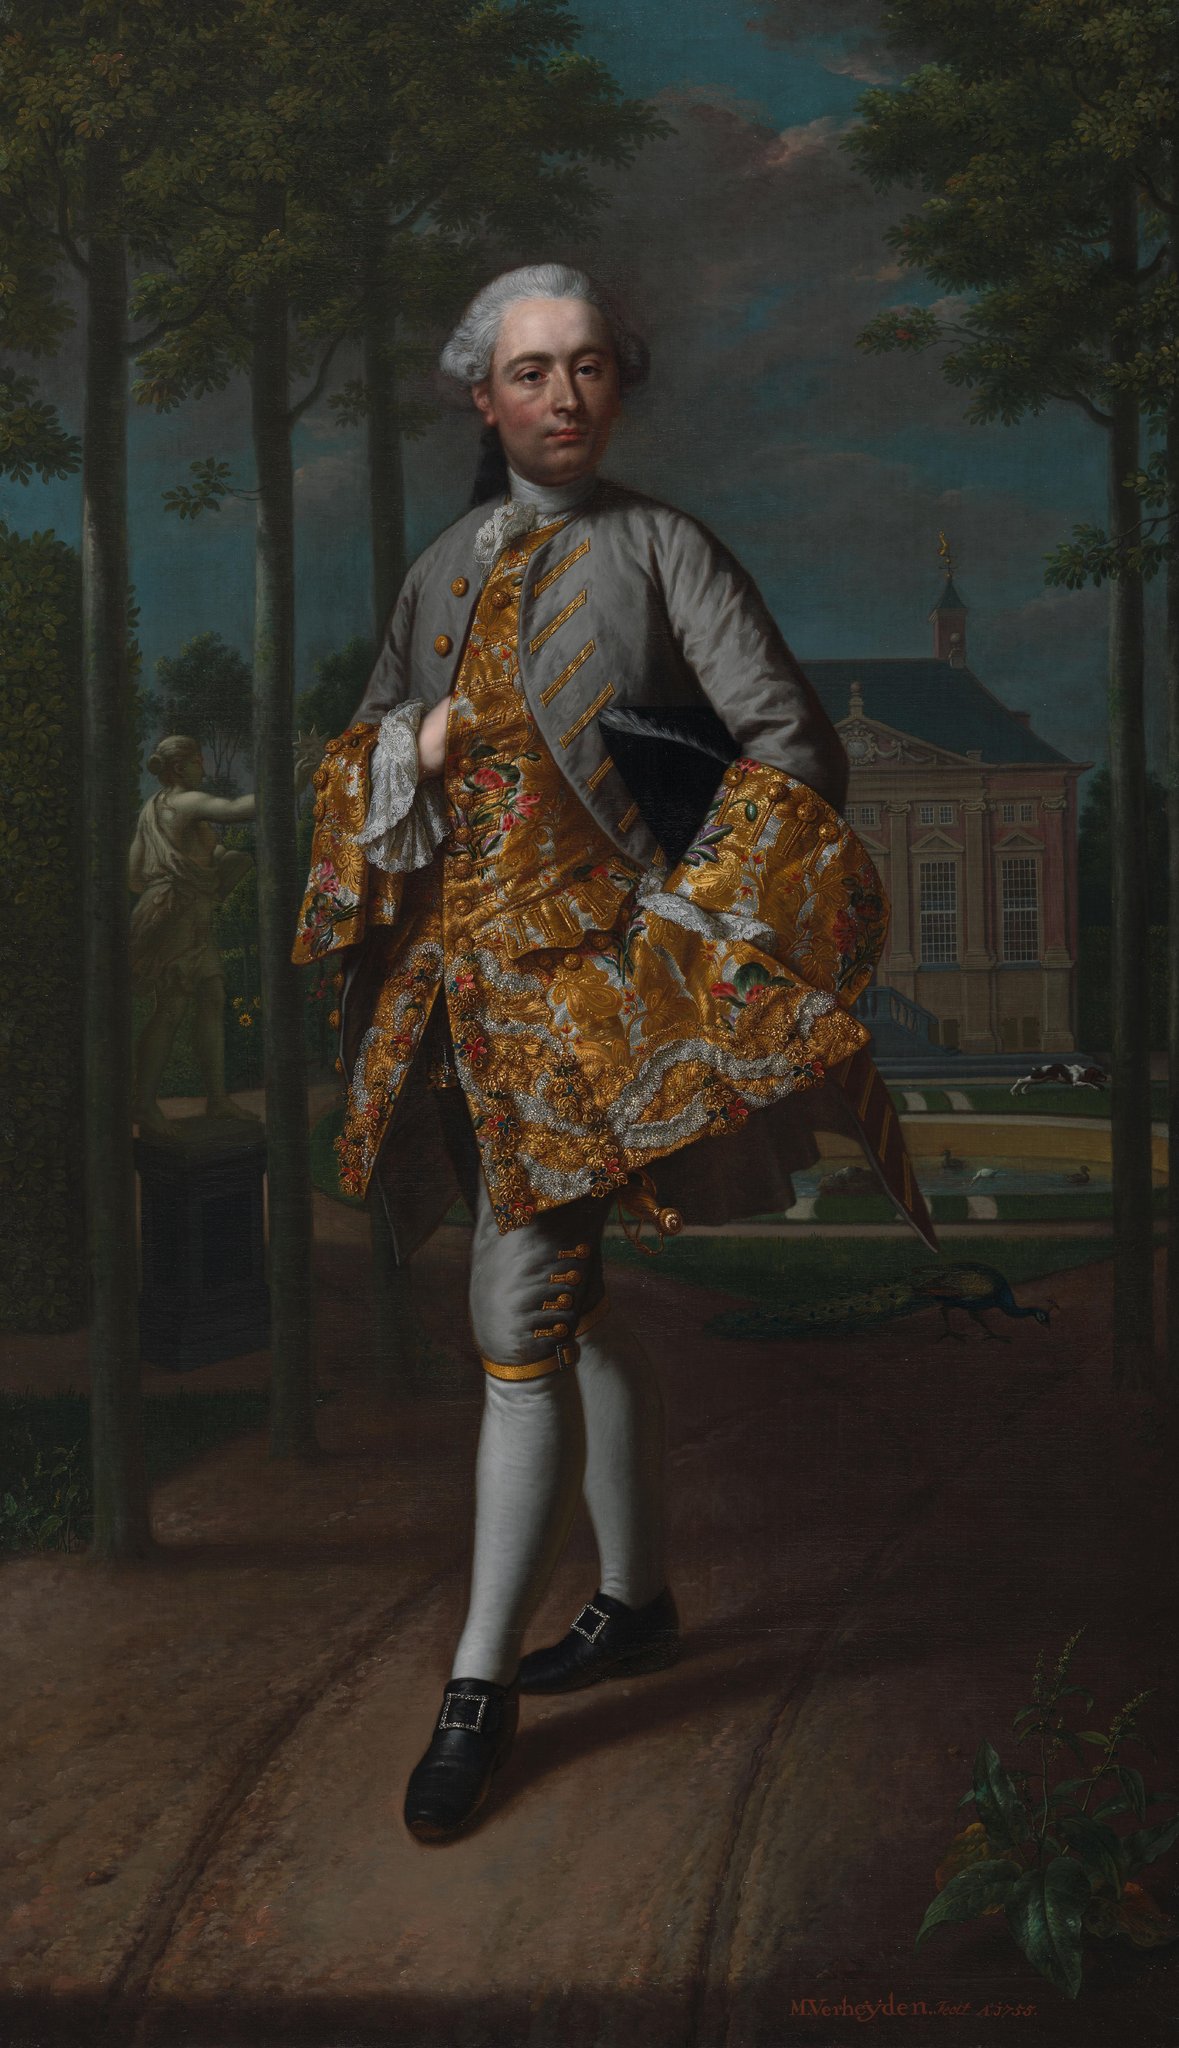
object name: painting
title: Gerard Cornelis van Riebeeck (1722-1759), Secretary of Delft, presumably standing in front of his Country House Essensteyn at Voorburg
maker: mattheus verheyden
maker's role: draughtsman, painter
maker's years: 1700-1777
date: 1755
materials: canvas, oil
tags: the hague, amsterdam, historical persons, rural housing, e.g. country-house, villa, cottage, voorburg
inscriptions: signature and date: ‘M. Verheijden Fecit Aº 1755’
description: The regent Gerard van Riebeeck oozes status. He is portrayed in front of Essesteijn, his country estate in Voorburg, where this painting along with the pendant of his wife Charlotte Strick van Linschoten (adjacent) hung as part of a portrait series that underscored the families’ prestige. Van Riebeeck wears a gold brocade waistcoat and matching cuffs. The abundance of buttons embellishing his attire, many of which serve no practical purpose, is striking.